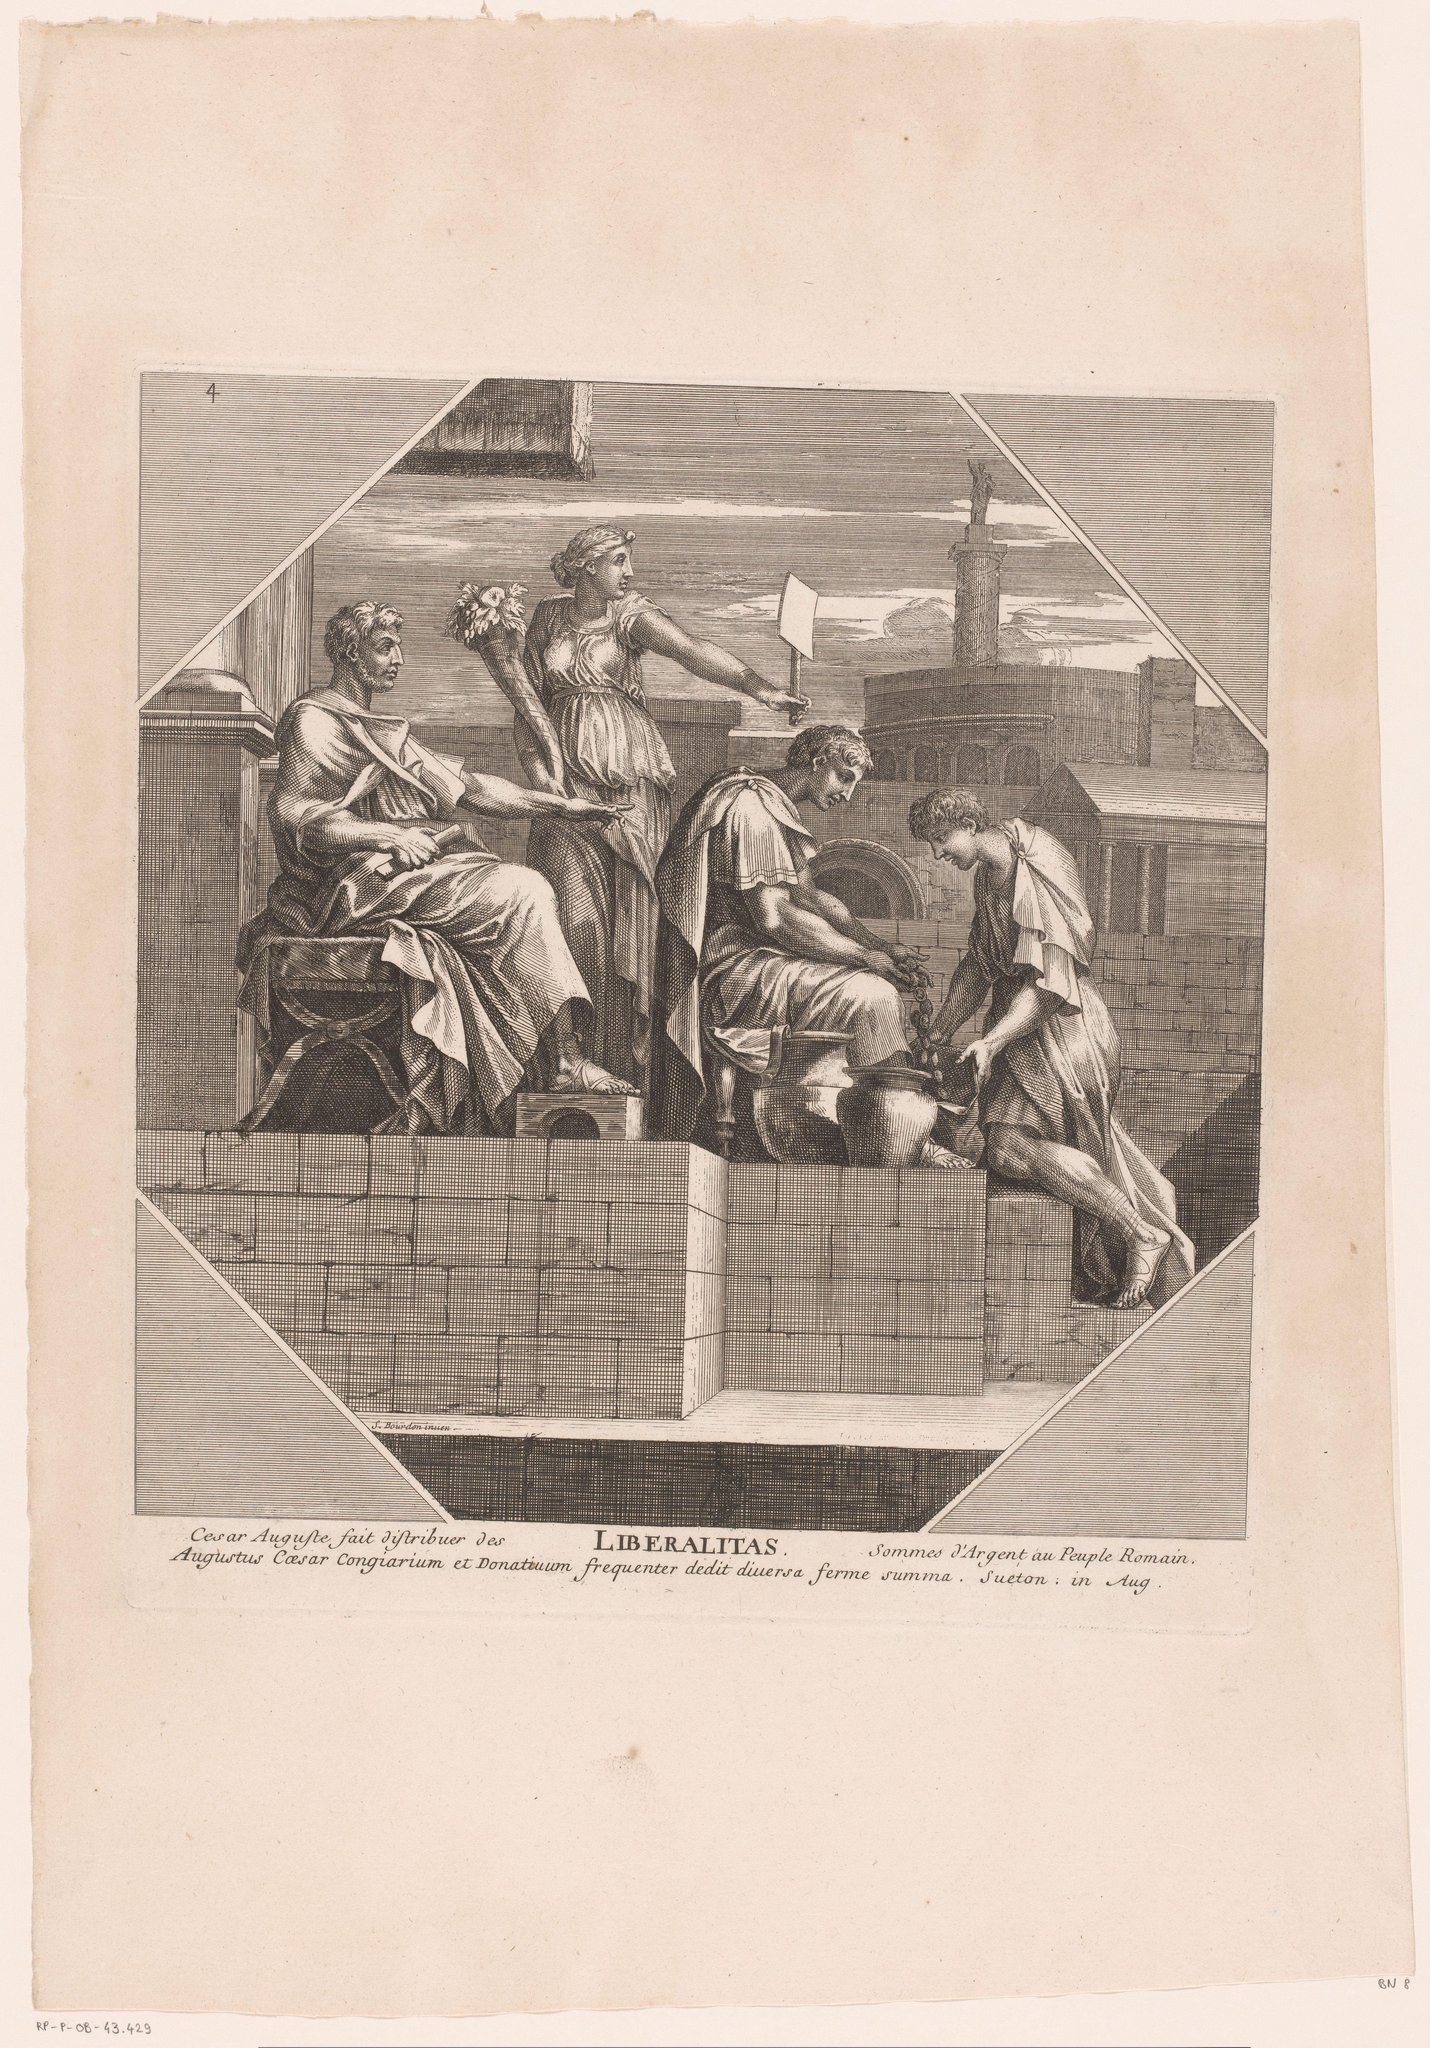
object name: print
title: Vrijgevigheid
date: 1663-1738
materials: paper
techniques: engraving, etching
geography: paris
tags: historical persons, generosity, liberality; 'generosità', 'liberalità' (ripa)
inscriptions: collector's mark: Lugt 2228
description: Maakt deel uit van een veertiendelige serie opgedeeld in twee reeksen, met als onderwerp de zeven vrije kunsten en deugden naar schilderijen door Sébastien Bourdon. De schilderijen werden in 1663 vervaardigd voor de Grande Galerie van het Hôtel de Bretonvilliers te Parijs.